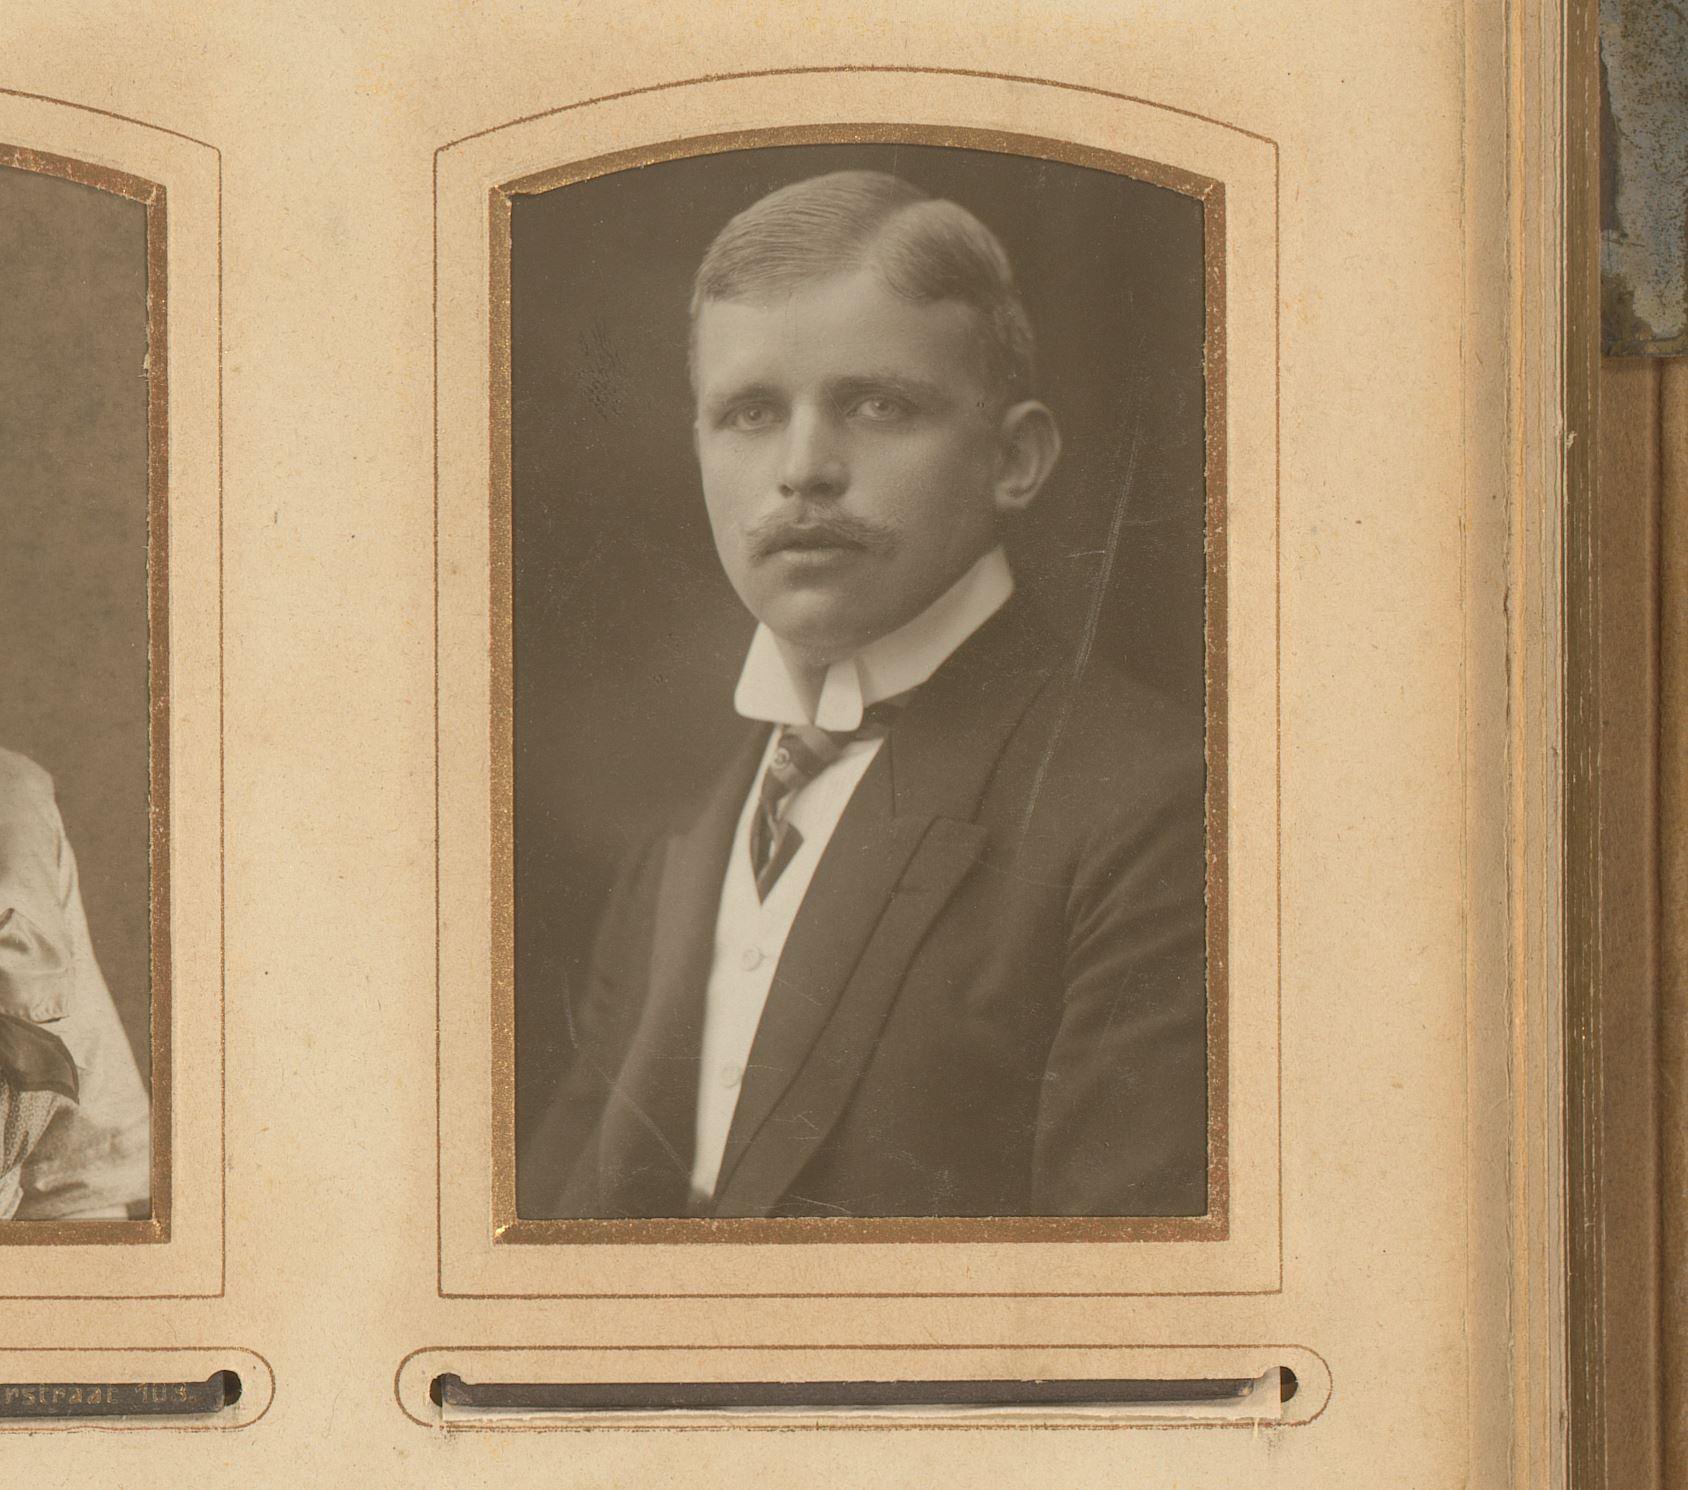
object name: photograph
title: Portret van een man met snor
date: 1890-1920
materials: cardboard, photographic support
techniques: collodion silver print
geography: dresden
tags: moustache, historical persons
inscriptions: inscription: ‘Han Nachfolger [...] Hofphotogr./ Dresden-Altstadt/ Ferdinand-Str. 11’